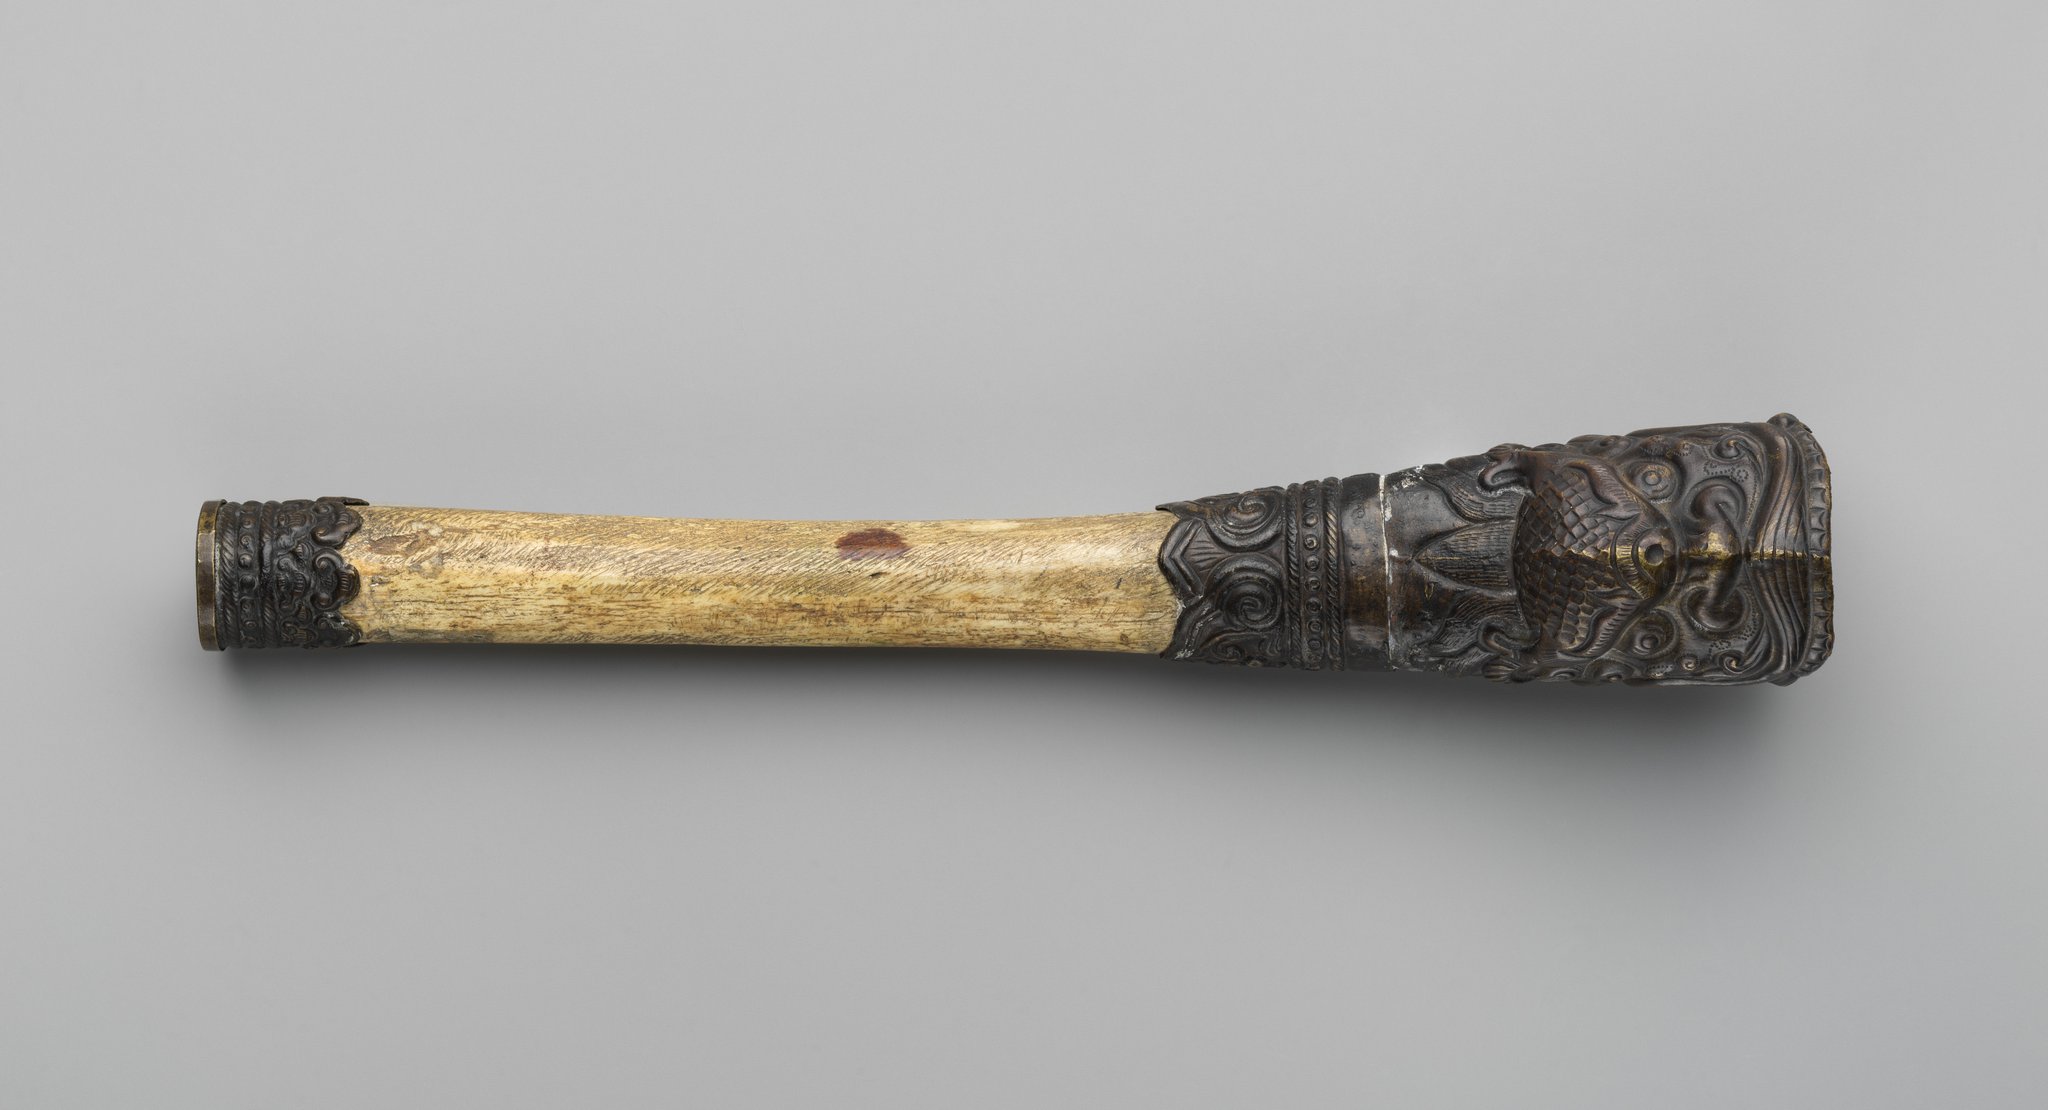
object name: rkan dung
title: Rkan-Dung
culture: chinese or tibetan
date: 1867-1900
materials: copper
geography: china